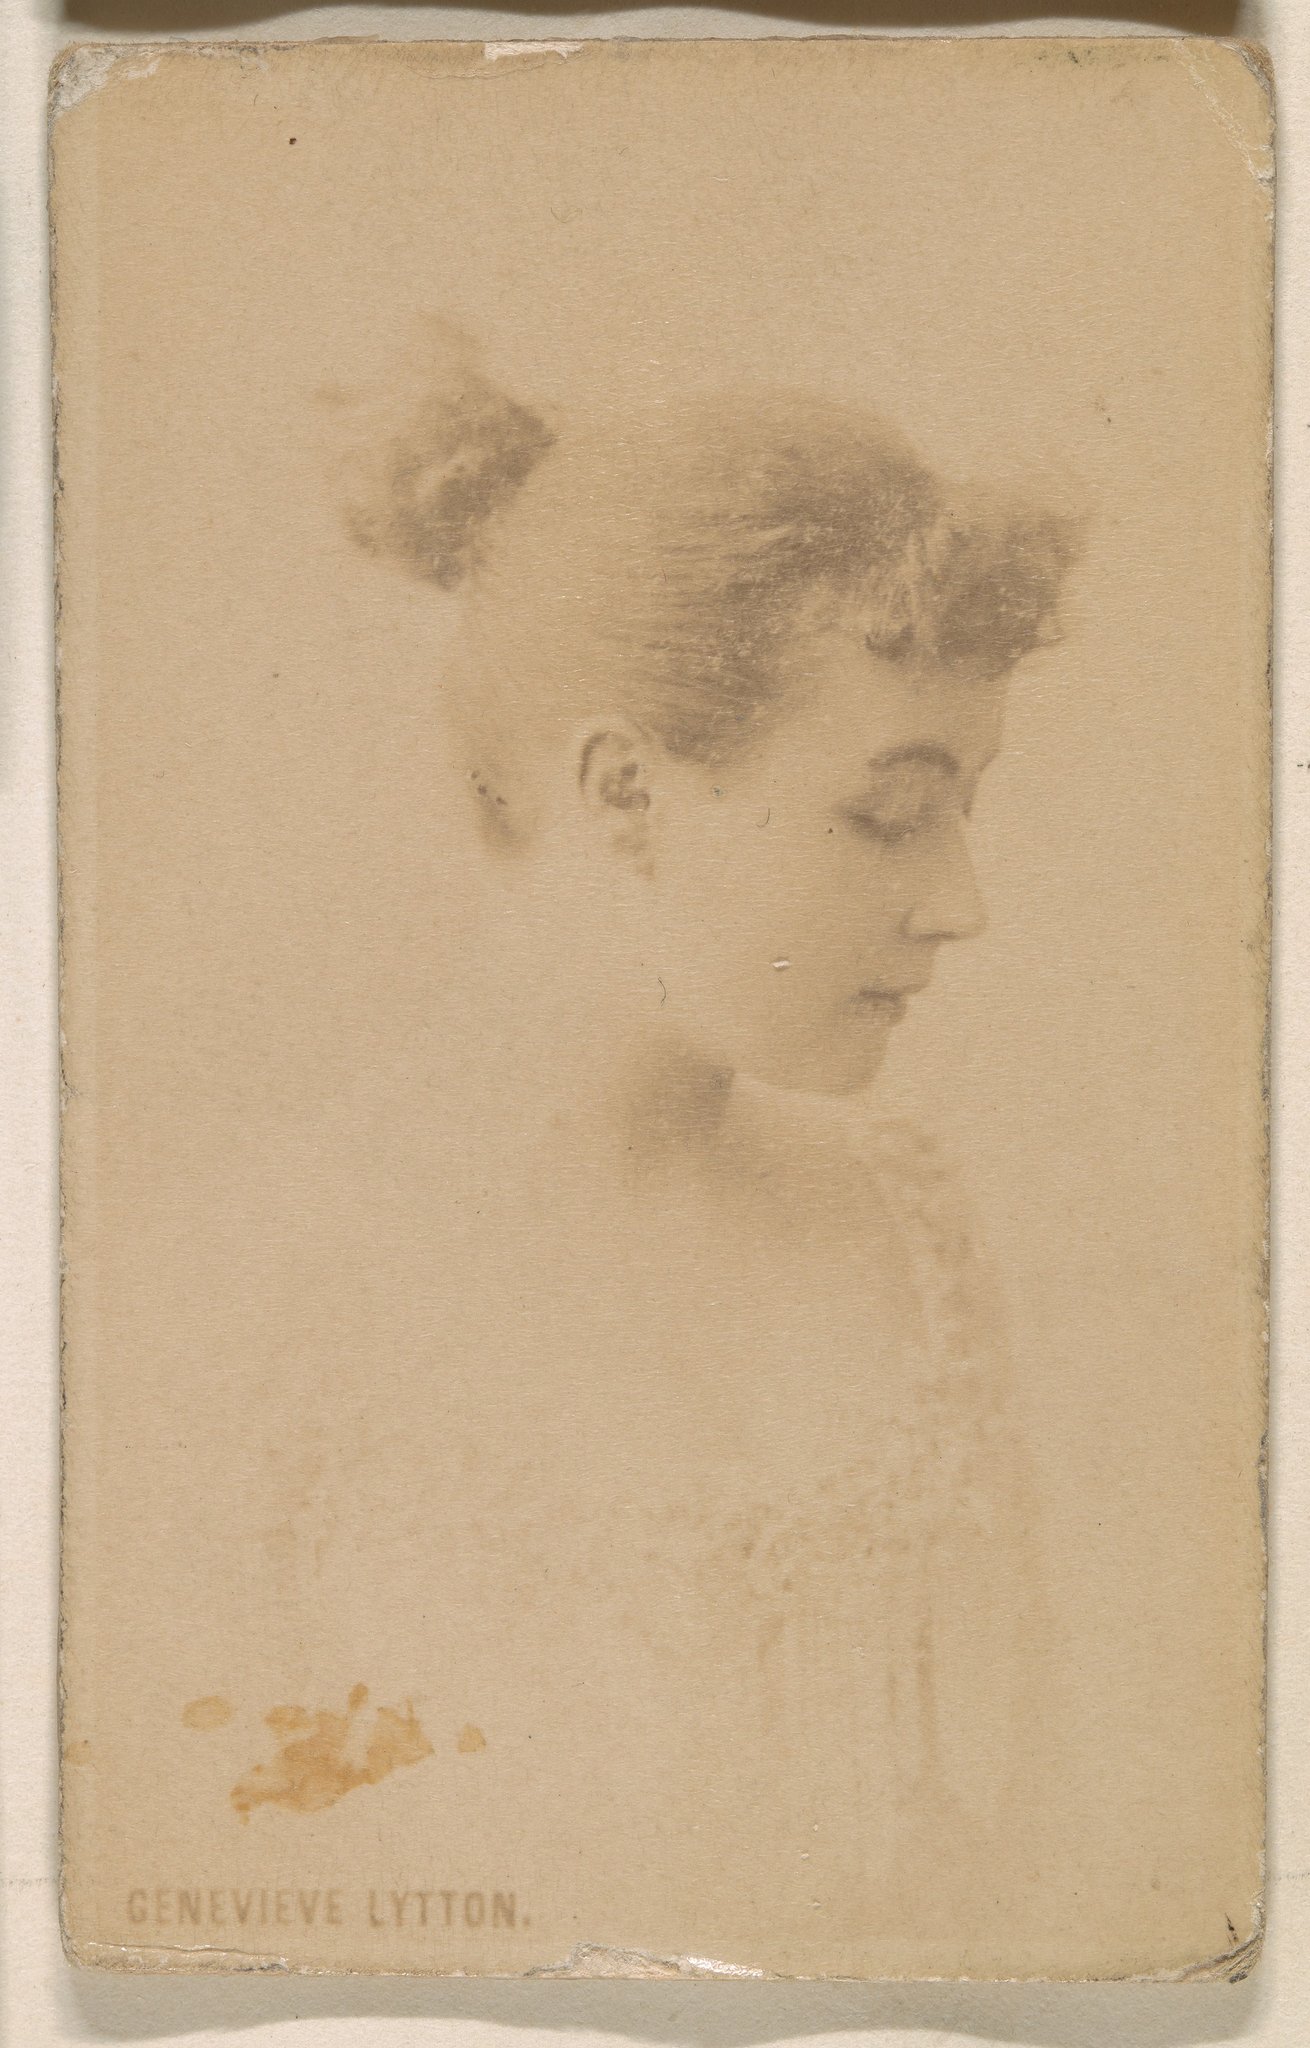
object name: photograph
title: Genevieve Lytton, from the Actresses series (N246), Type 1, issued by Kinney Brothers to promote Sporting Extra Cigarettes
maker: kinney brothers tobacco company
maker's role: publisher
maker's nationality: american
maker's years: 1869-2011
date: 1890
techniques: albumen silver print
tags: profiles,women,actresses